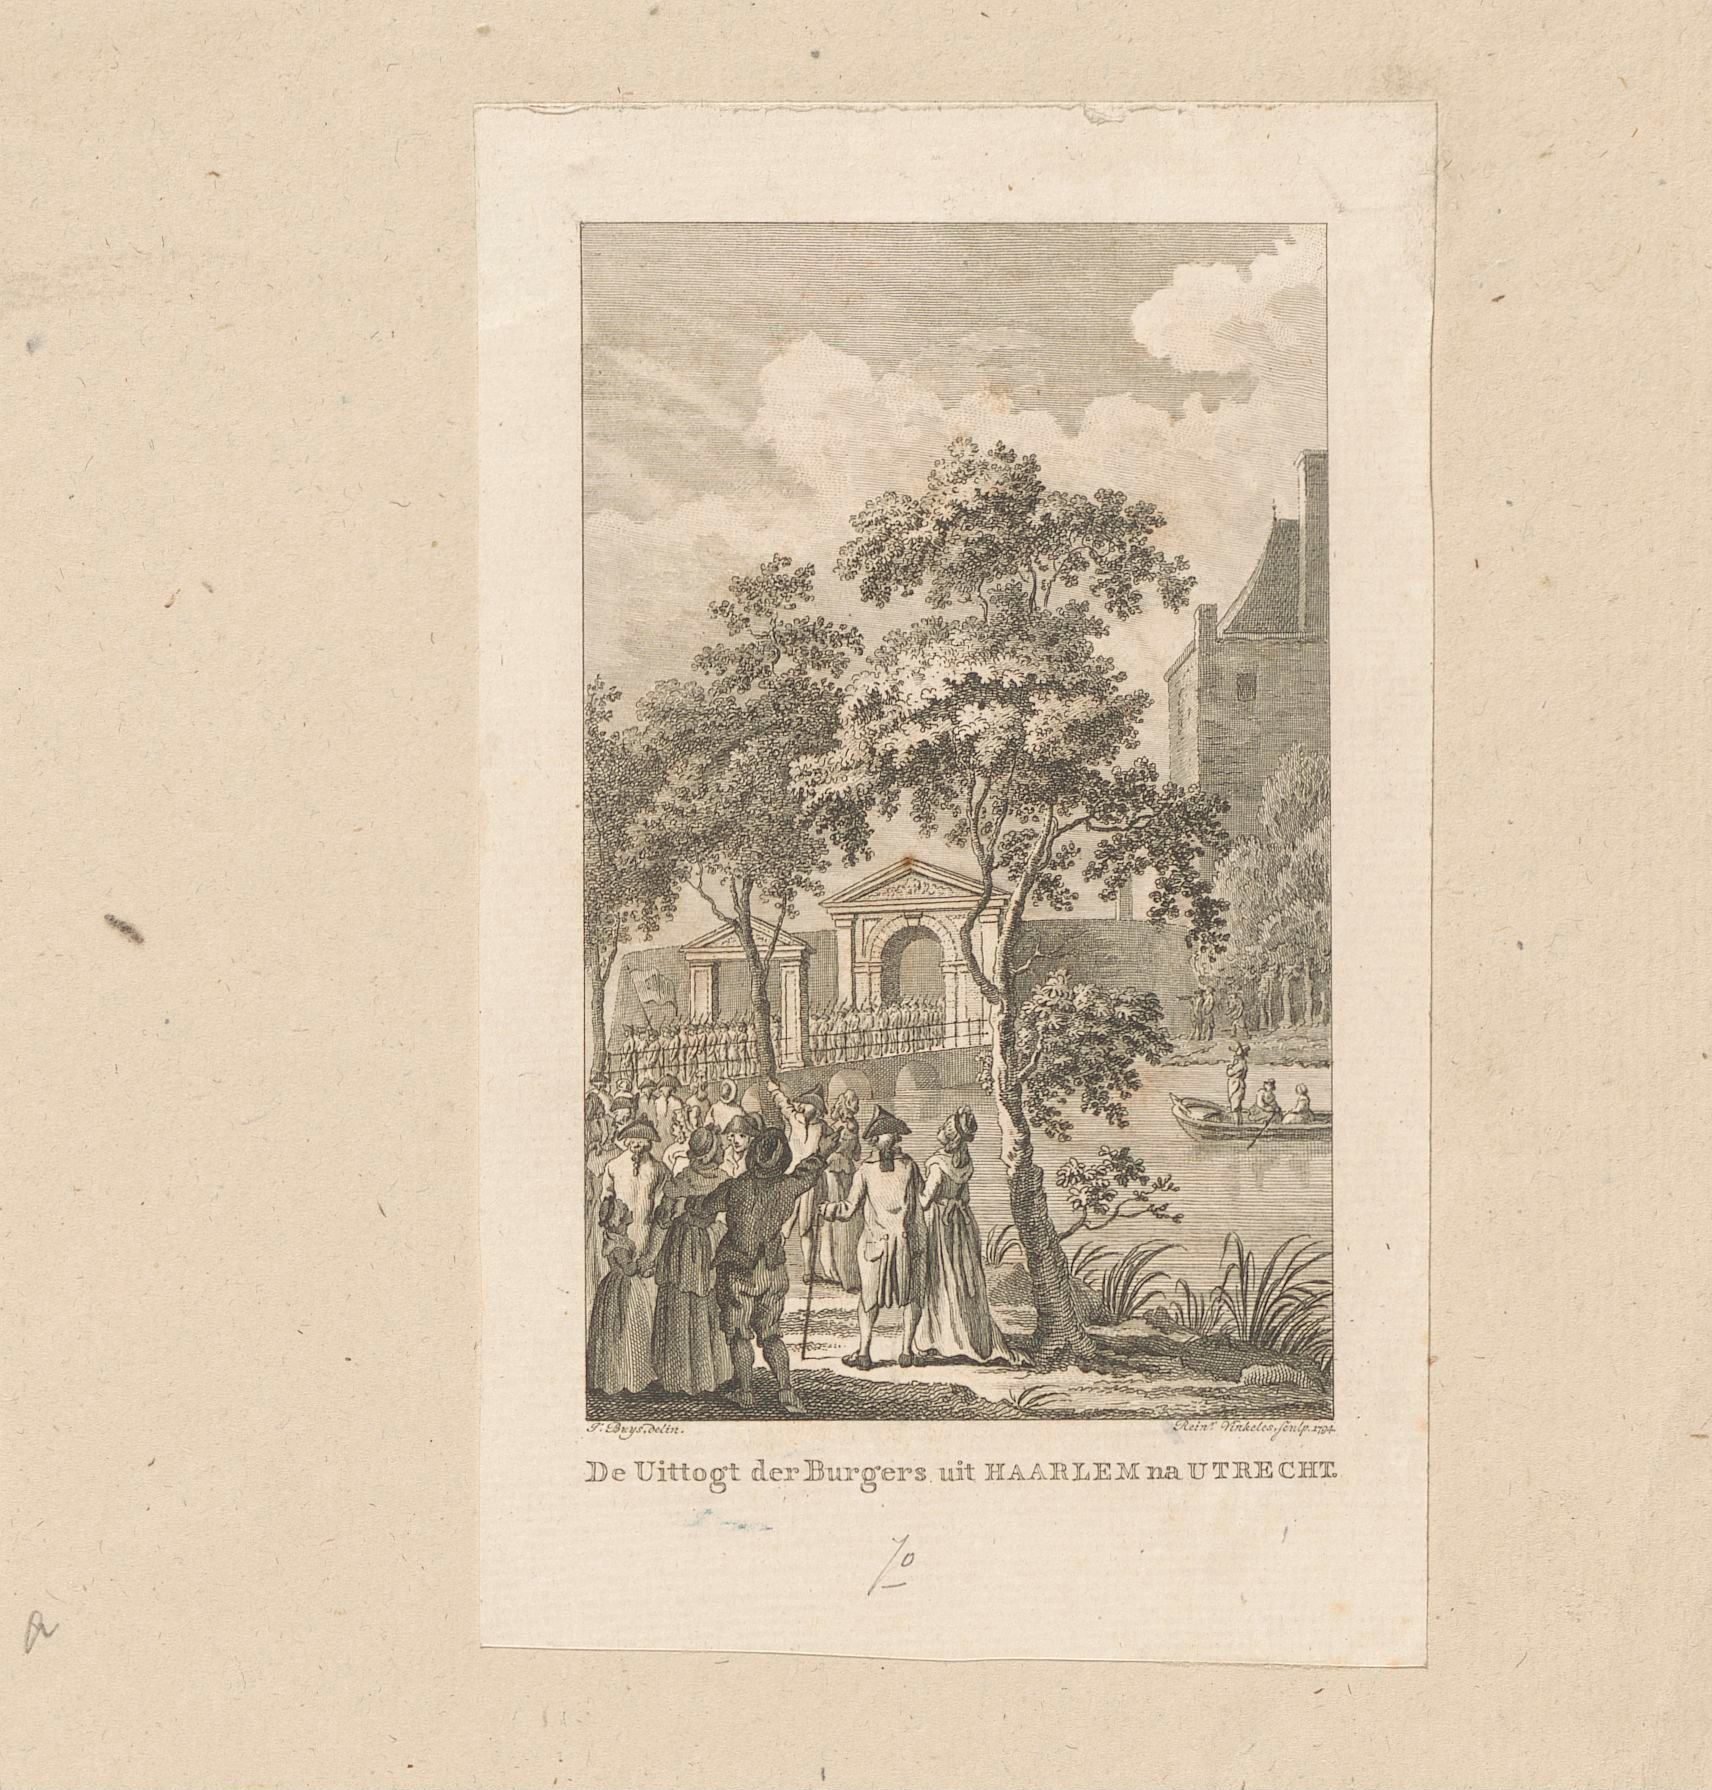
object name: print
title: De uittogt der burgers uit Haarlem na Utrecht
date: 1794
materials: paper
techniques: engraving, etching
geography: amsterdam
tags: troop movements, transportation (+ citizen soldiery, civil guard, citizen militia), haarlem, patriots (1780-1795)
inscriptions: date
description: Prent ook gebruikt in: Loosjes, P.A. Vaderlandsche historie, vervattende de geschiedenissen der Vereenigde Nederlanden (…) Ten vervolge van Wagenaars Vaderlandsche historie. 48 delen. Amsterdam: Johannes Allart, 1786-1811, dl. 12 (1794).